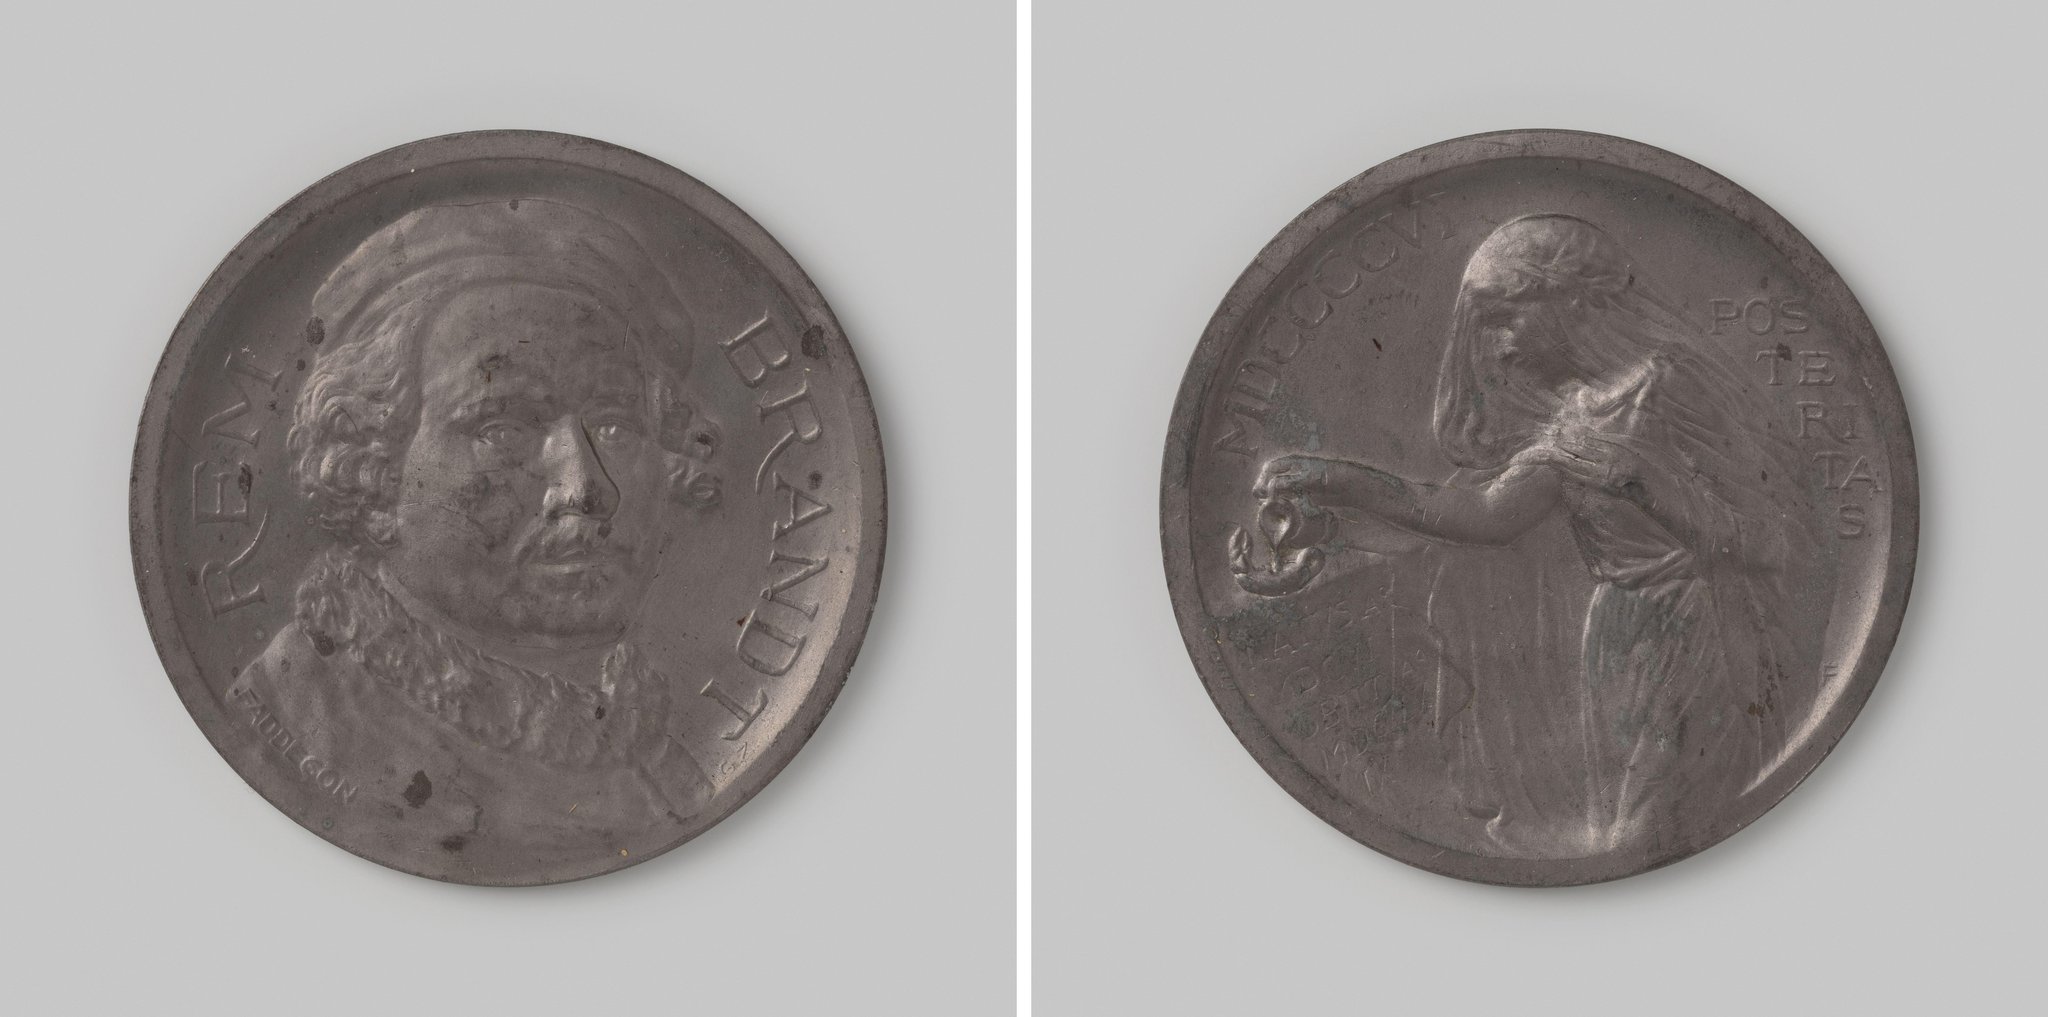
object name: history medal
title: Driehonderdste geboortedag van Rembrandt van Rijn 1906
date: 1905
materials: tin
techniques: striking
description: Tinnen penning, op de voorzijde het borstbeeld van Rembrandt half van rechts met omschrift, op de keerzijde een gesluierde vrouw naar links die een olielamp vult, met omschrift bovenaan en beiderzijds tekst in het veld.